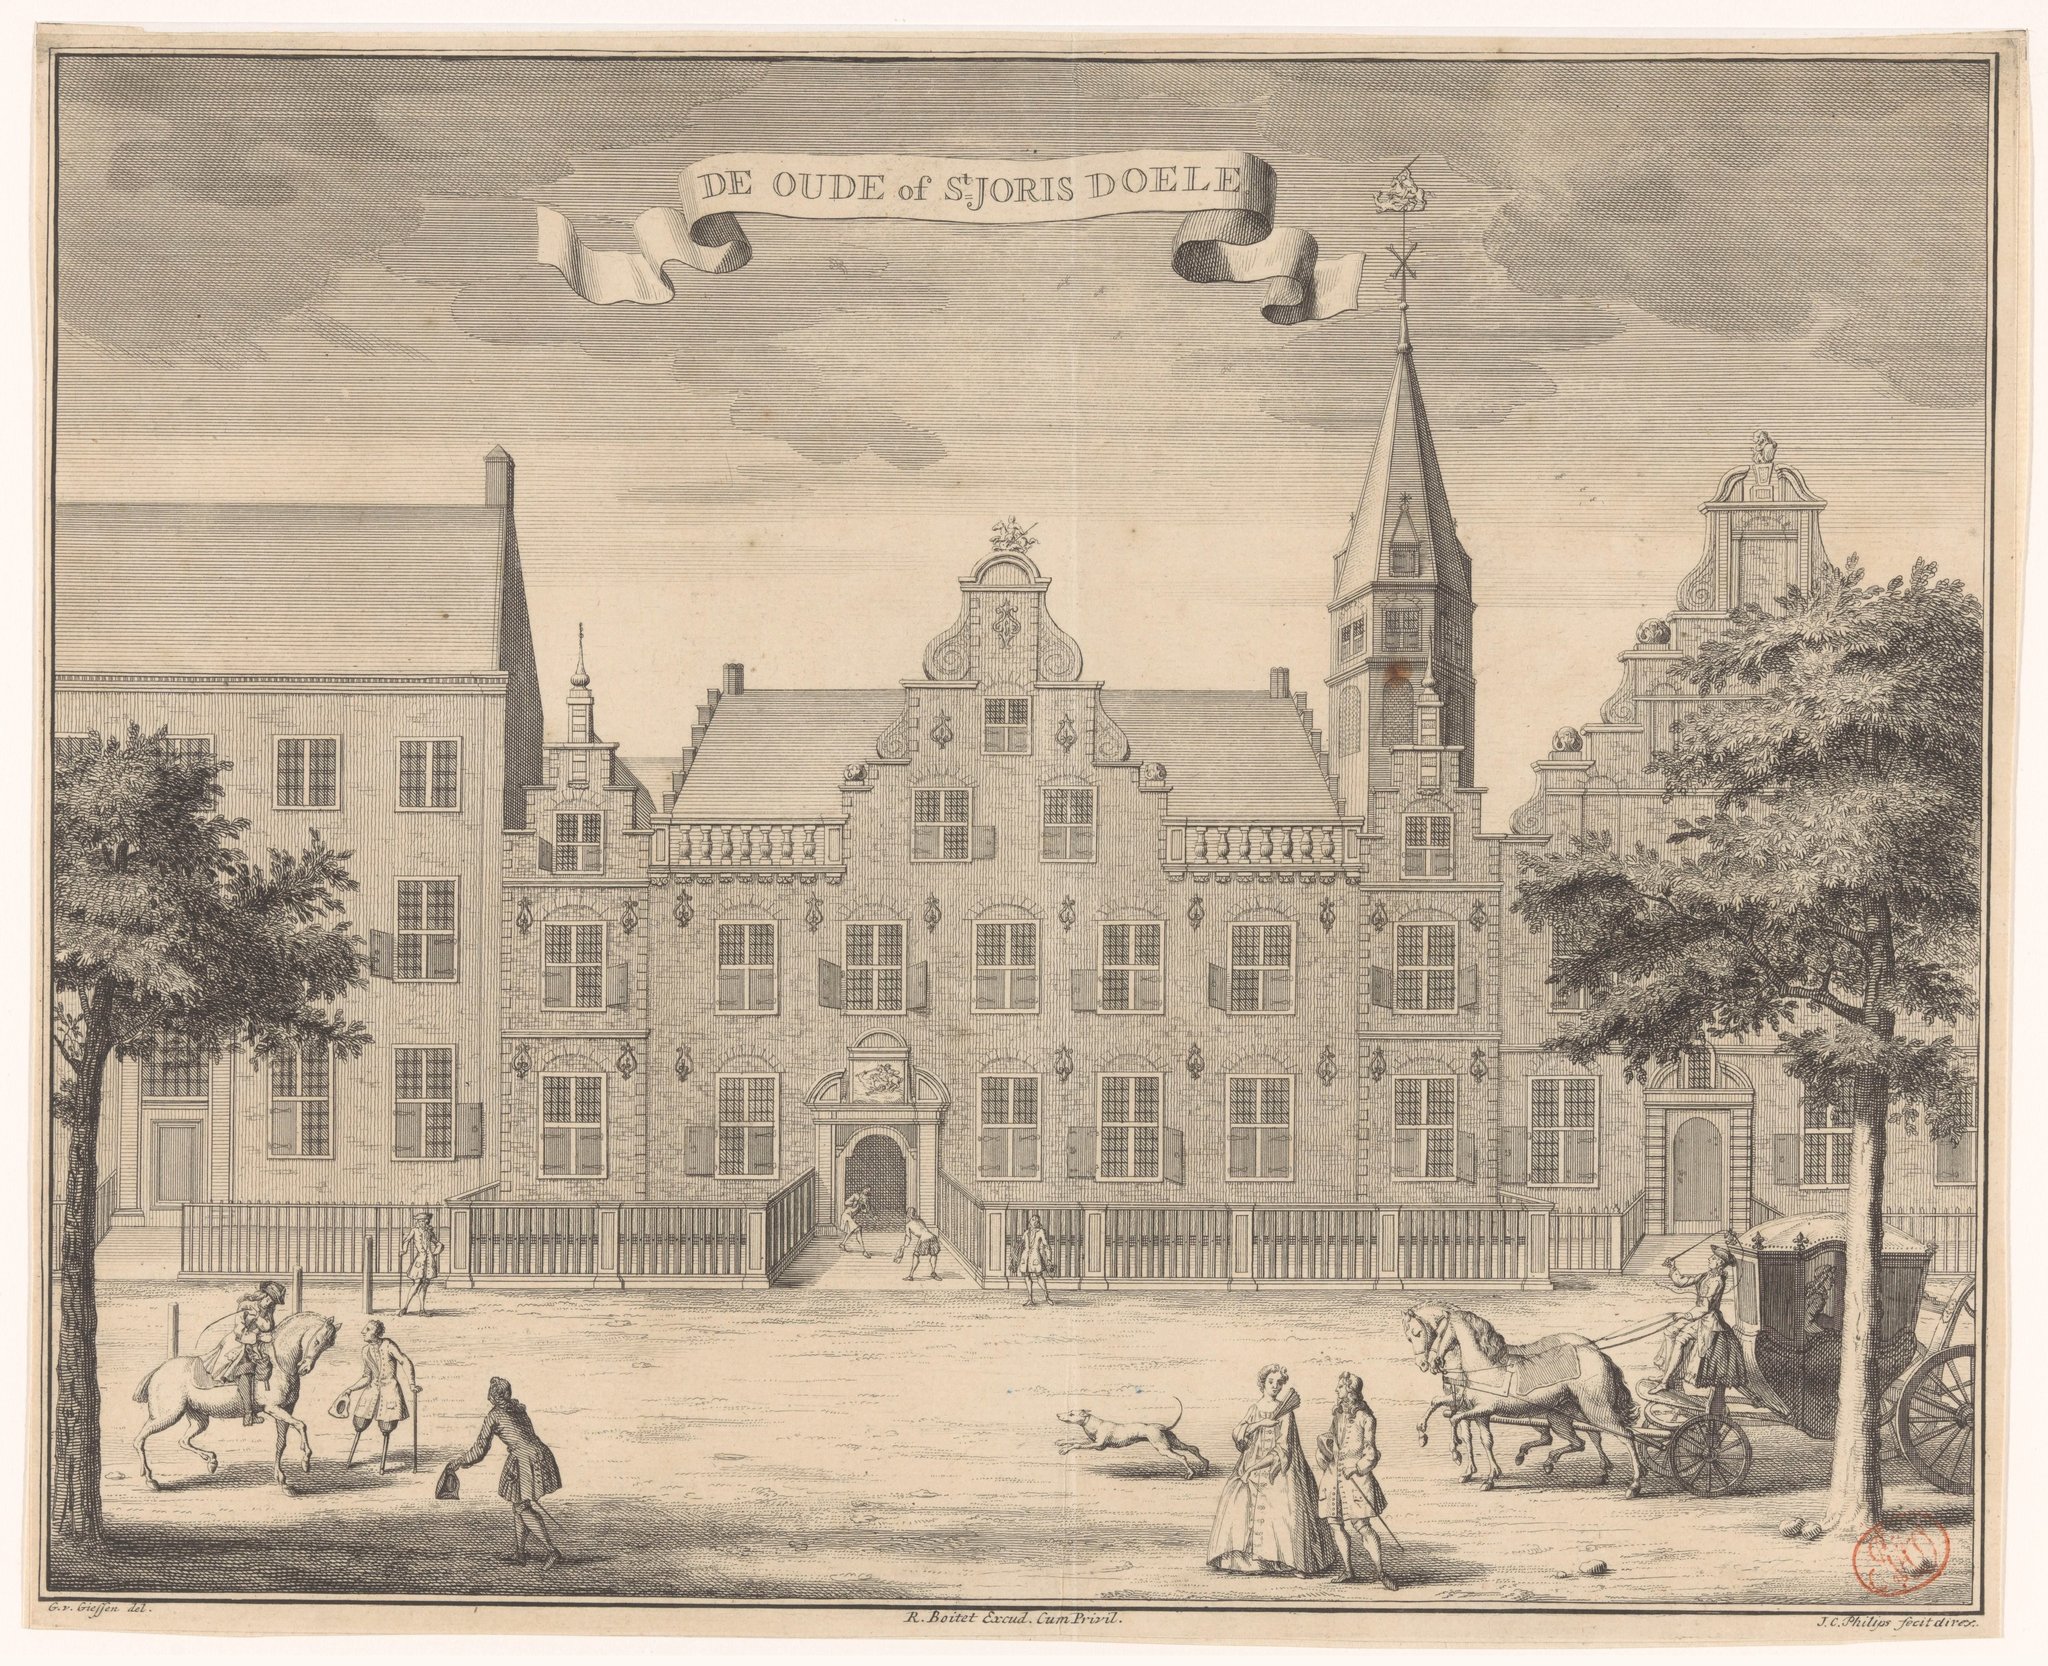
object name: book illustration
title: Gezicht op de Sint-Jorisdoelen te Den Haag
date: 1730-1736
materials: paper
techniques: engraving, etching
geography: the hague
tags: exterior ~ representation of a building, city-view, and landscape with man-made constructions (+ city(-scape) with figures, staffage)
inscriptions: collector's mark: Lugt 2228, collector's mark: Lugt 195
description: Gezicht op de Sint-Jorisdoelen, ook wel Oude Doelen genoemd, aan het Tournooiveld te Den Haag. Voor het gebouw verschillende figuren, een ruiter en een koets. Op de toren een windvaan met Sint Joris die de draak doodt.